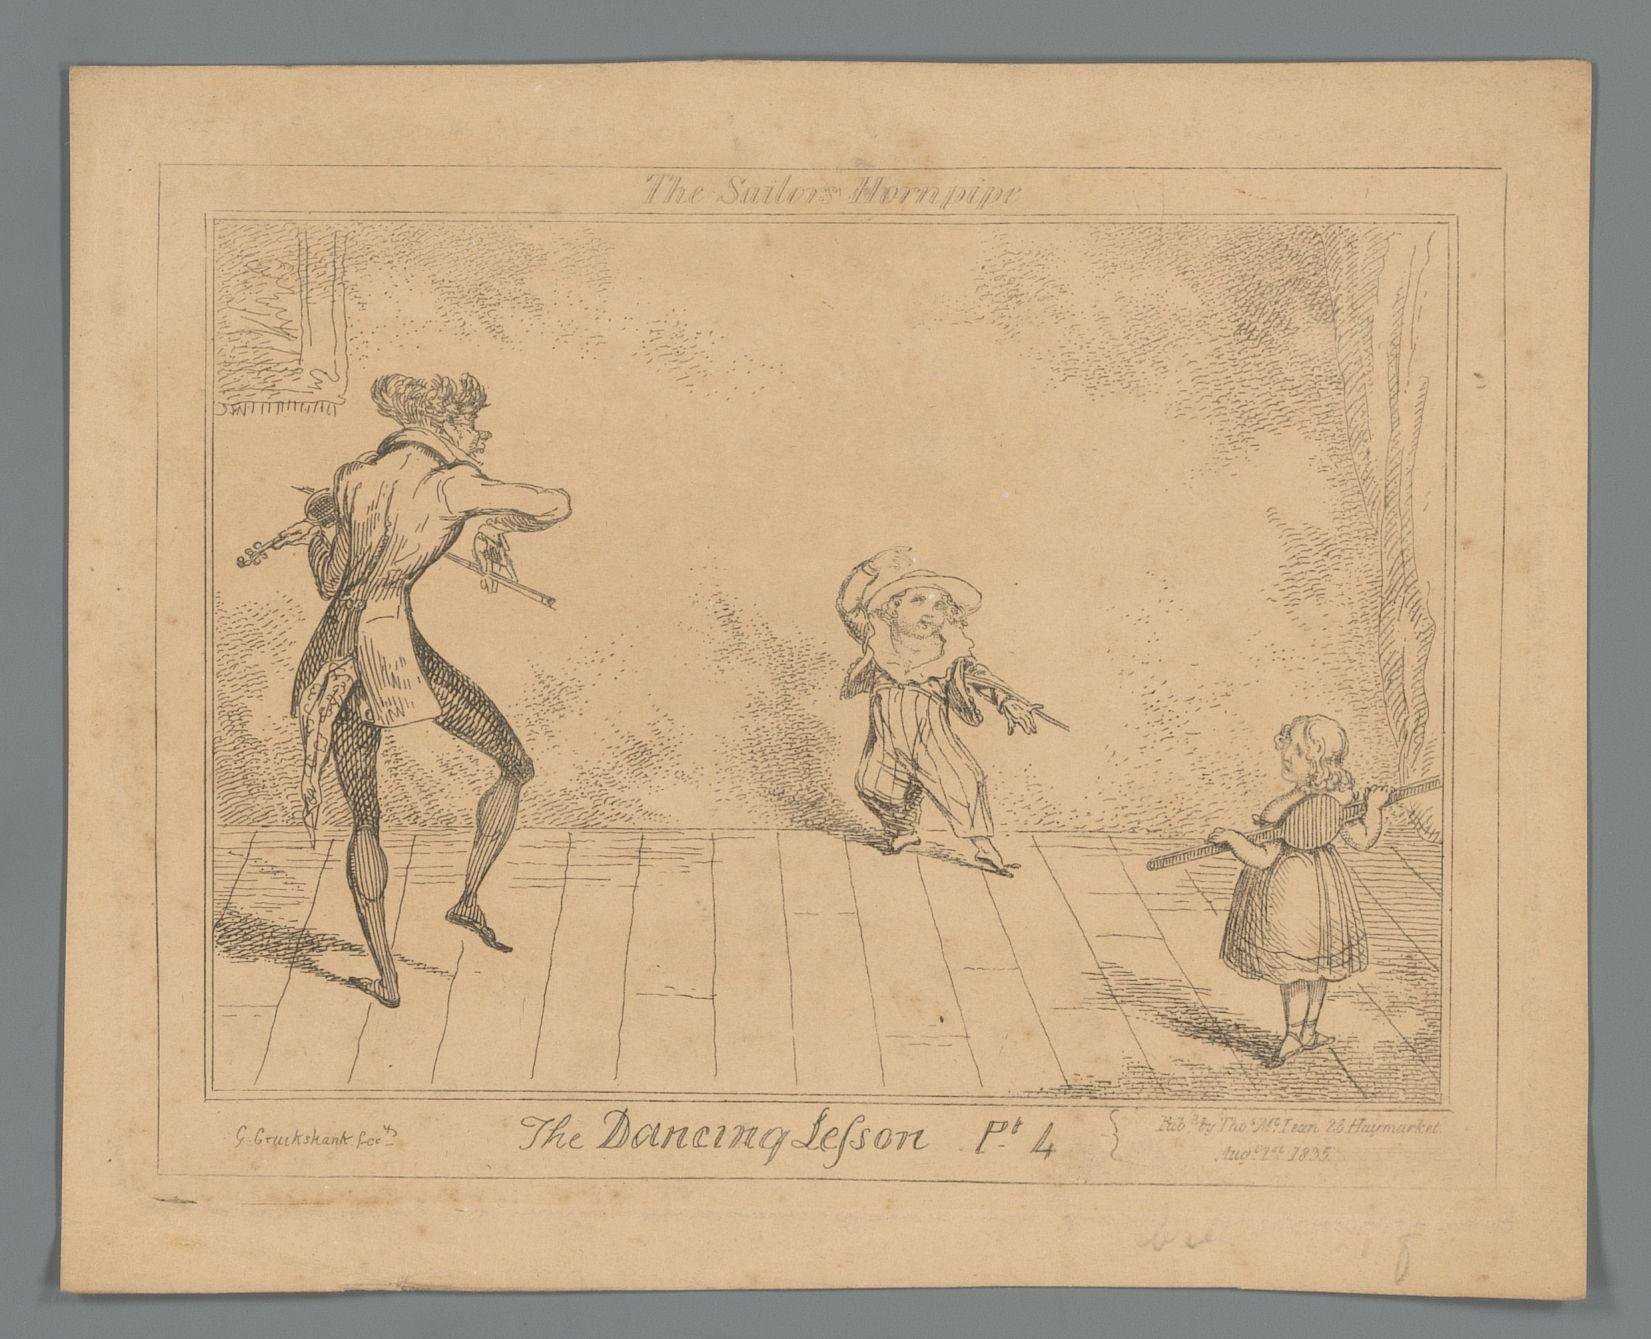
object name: print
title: Jongen op dansles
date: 1825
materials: paper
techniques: etching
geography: england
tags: man dancing alone, political caricatures and satires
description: Dansles. Een jongen in een matrozenpakje krijgt dansles van een dansmeester. Een meisje kijkt toe. Uit een groep van vier platen.